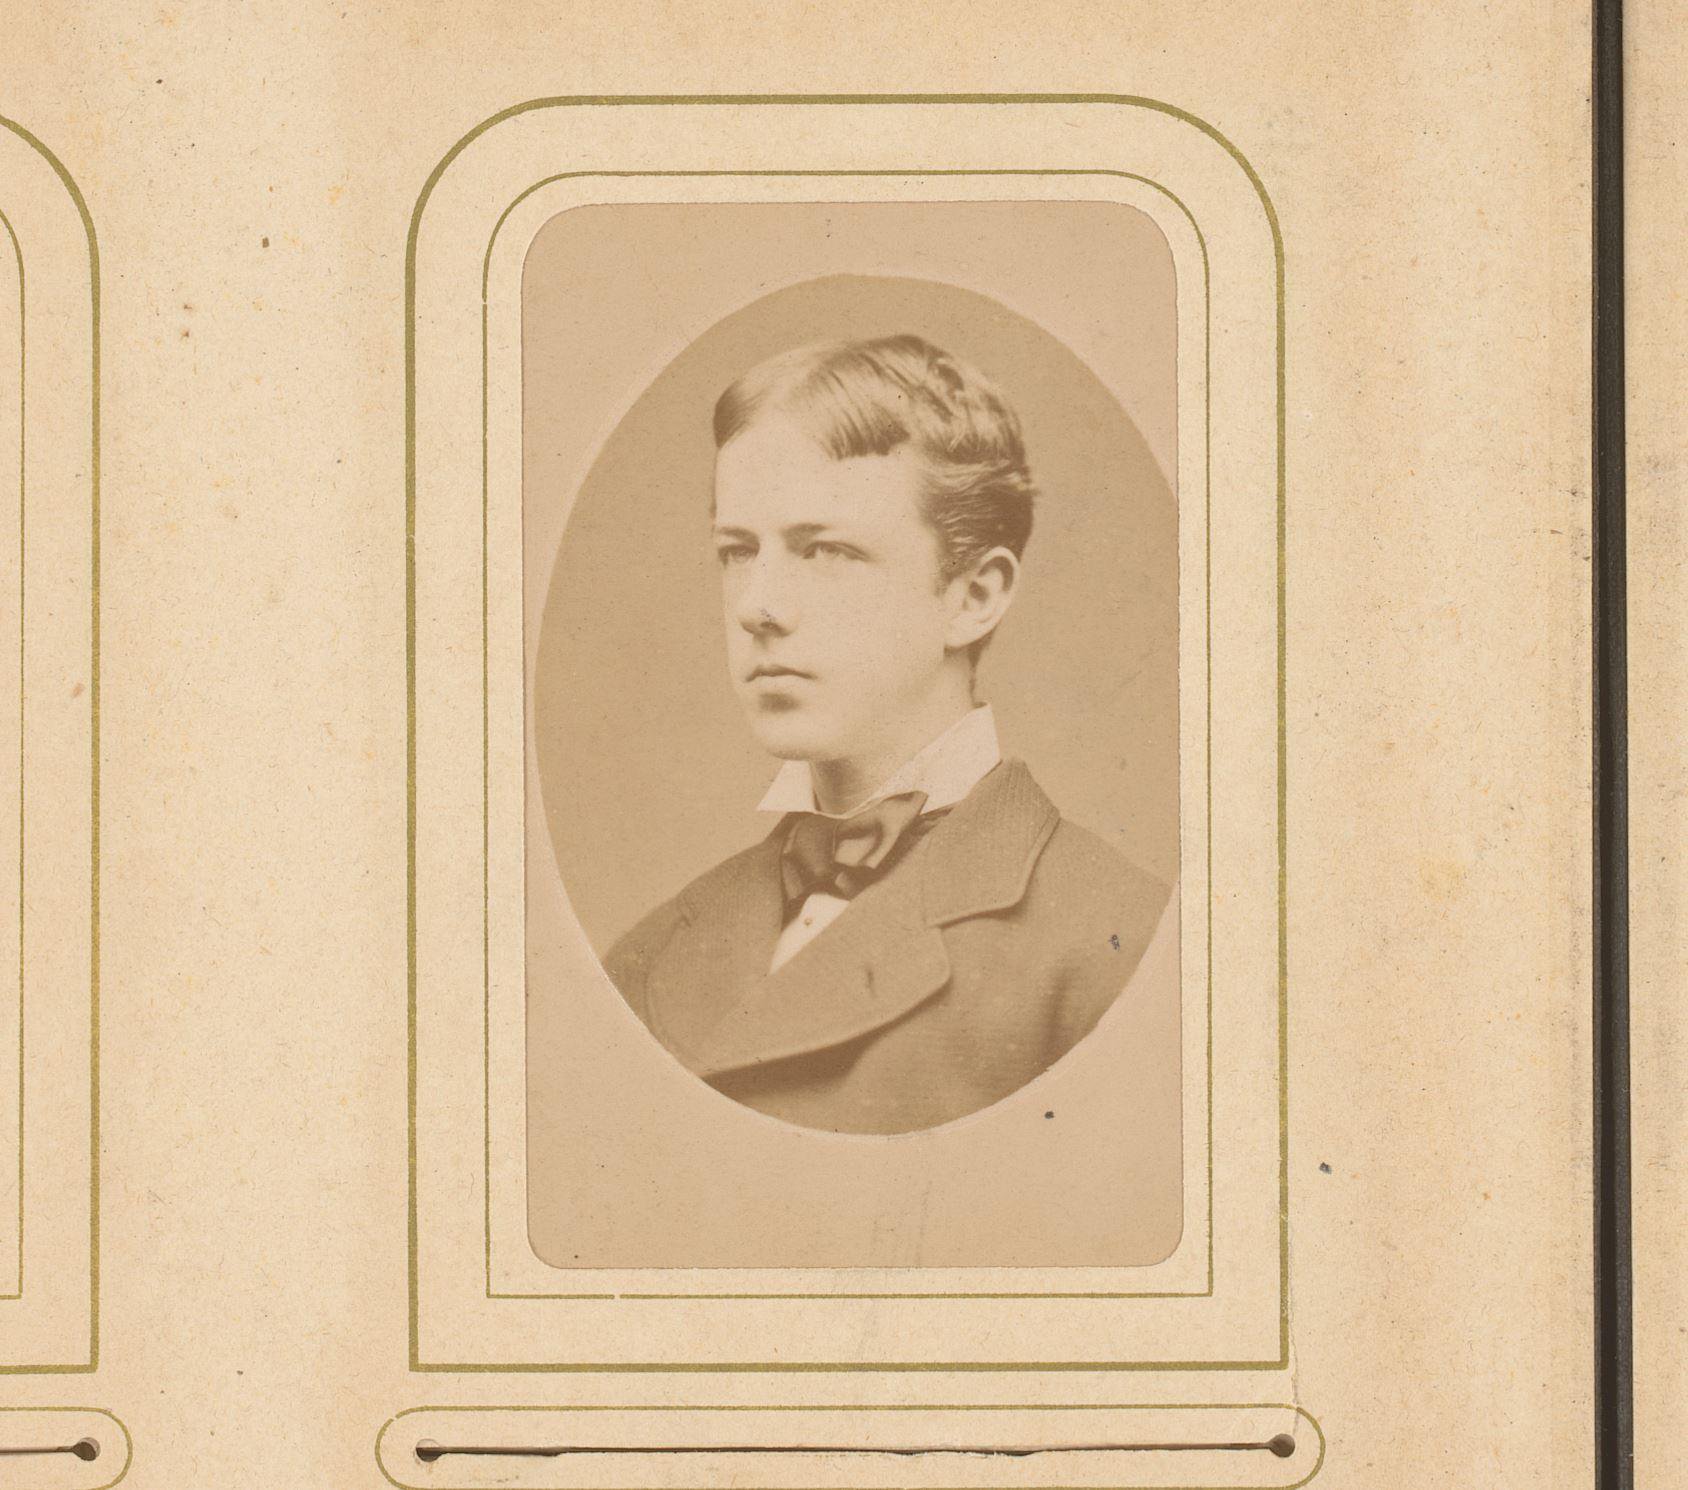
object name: carte de visite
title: Portret van een jonge man met vlinderstrik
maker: ed. radermacher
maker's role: fotograaf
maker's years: 1839-1908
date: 1871-1893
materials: cardboard, photographic support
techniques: albumen print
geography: rotterdam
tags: historical persons, youth, adolescent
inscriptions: inscription: ‘ED. RADERMACHER/ KRUISKADE/ ROTTERDAM/ HOEK KERKLAAN/ PHOTOGRAPHE’